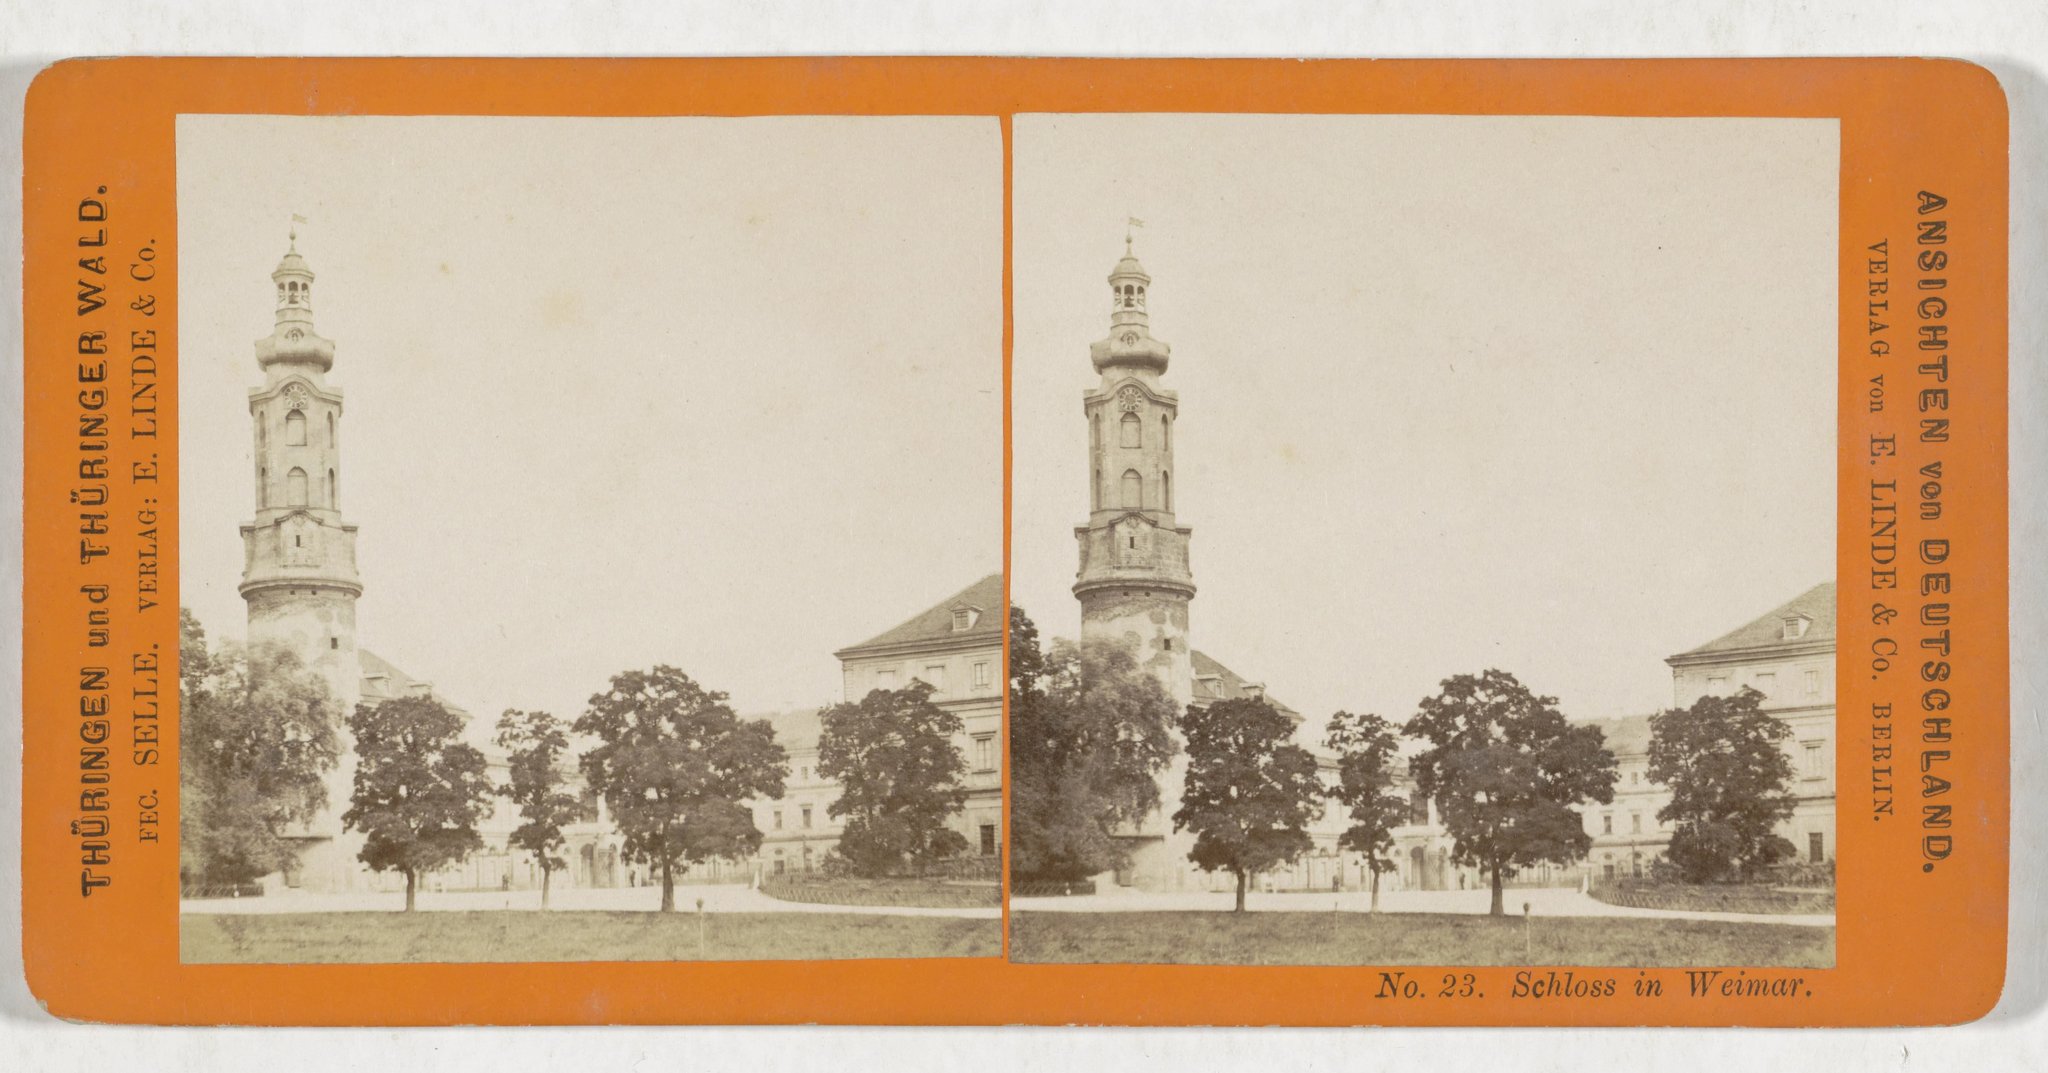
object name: stereograph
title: Ansichten von Deutschland / Thüringen und Thüringer Wald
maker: hermann selle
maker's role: fotograaf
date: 1868-1890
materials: cardboard, paper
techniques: albumen print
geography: weimar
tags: palace, tower (of house or building)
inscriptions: number: ‘No. 23.’